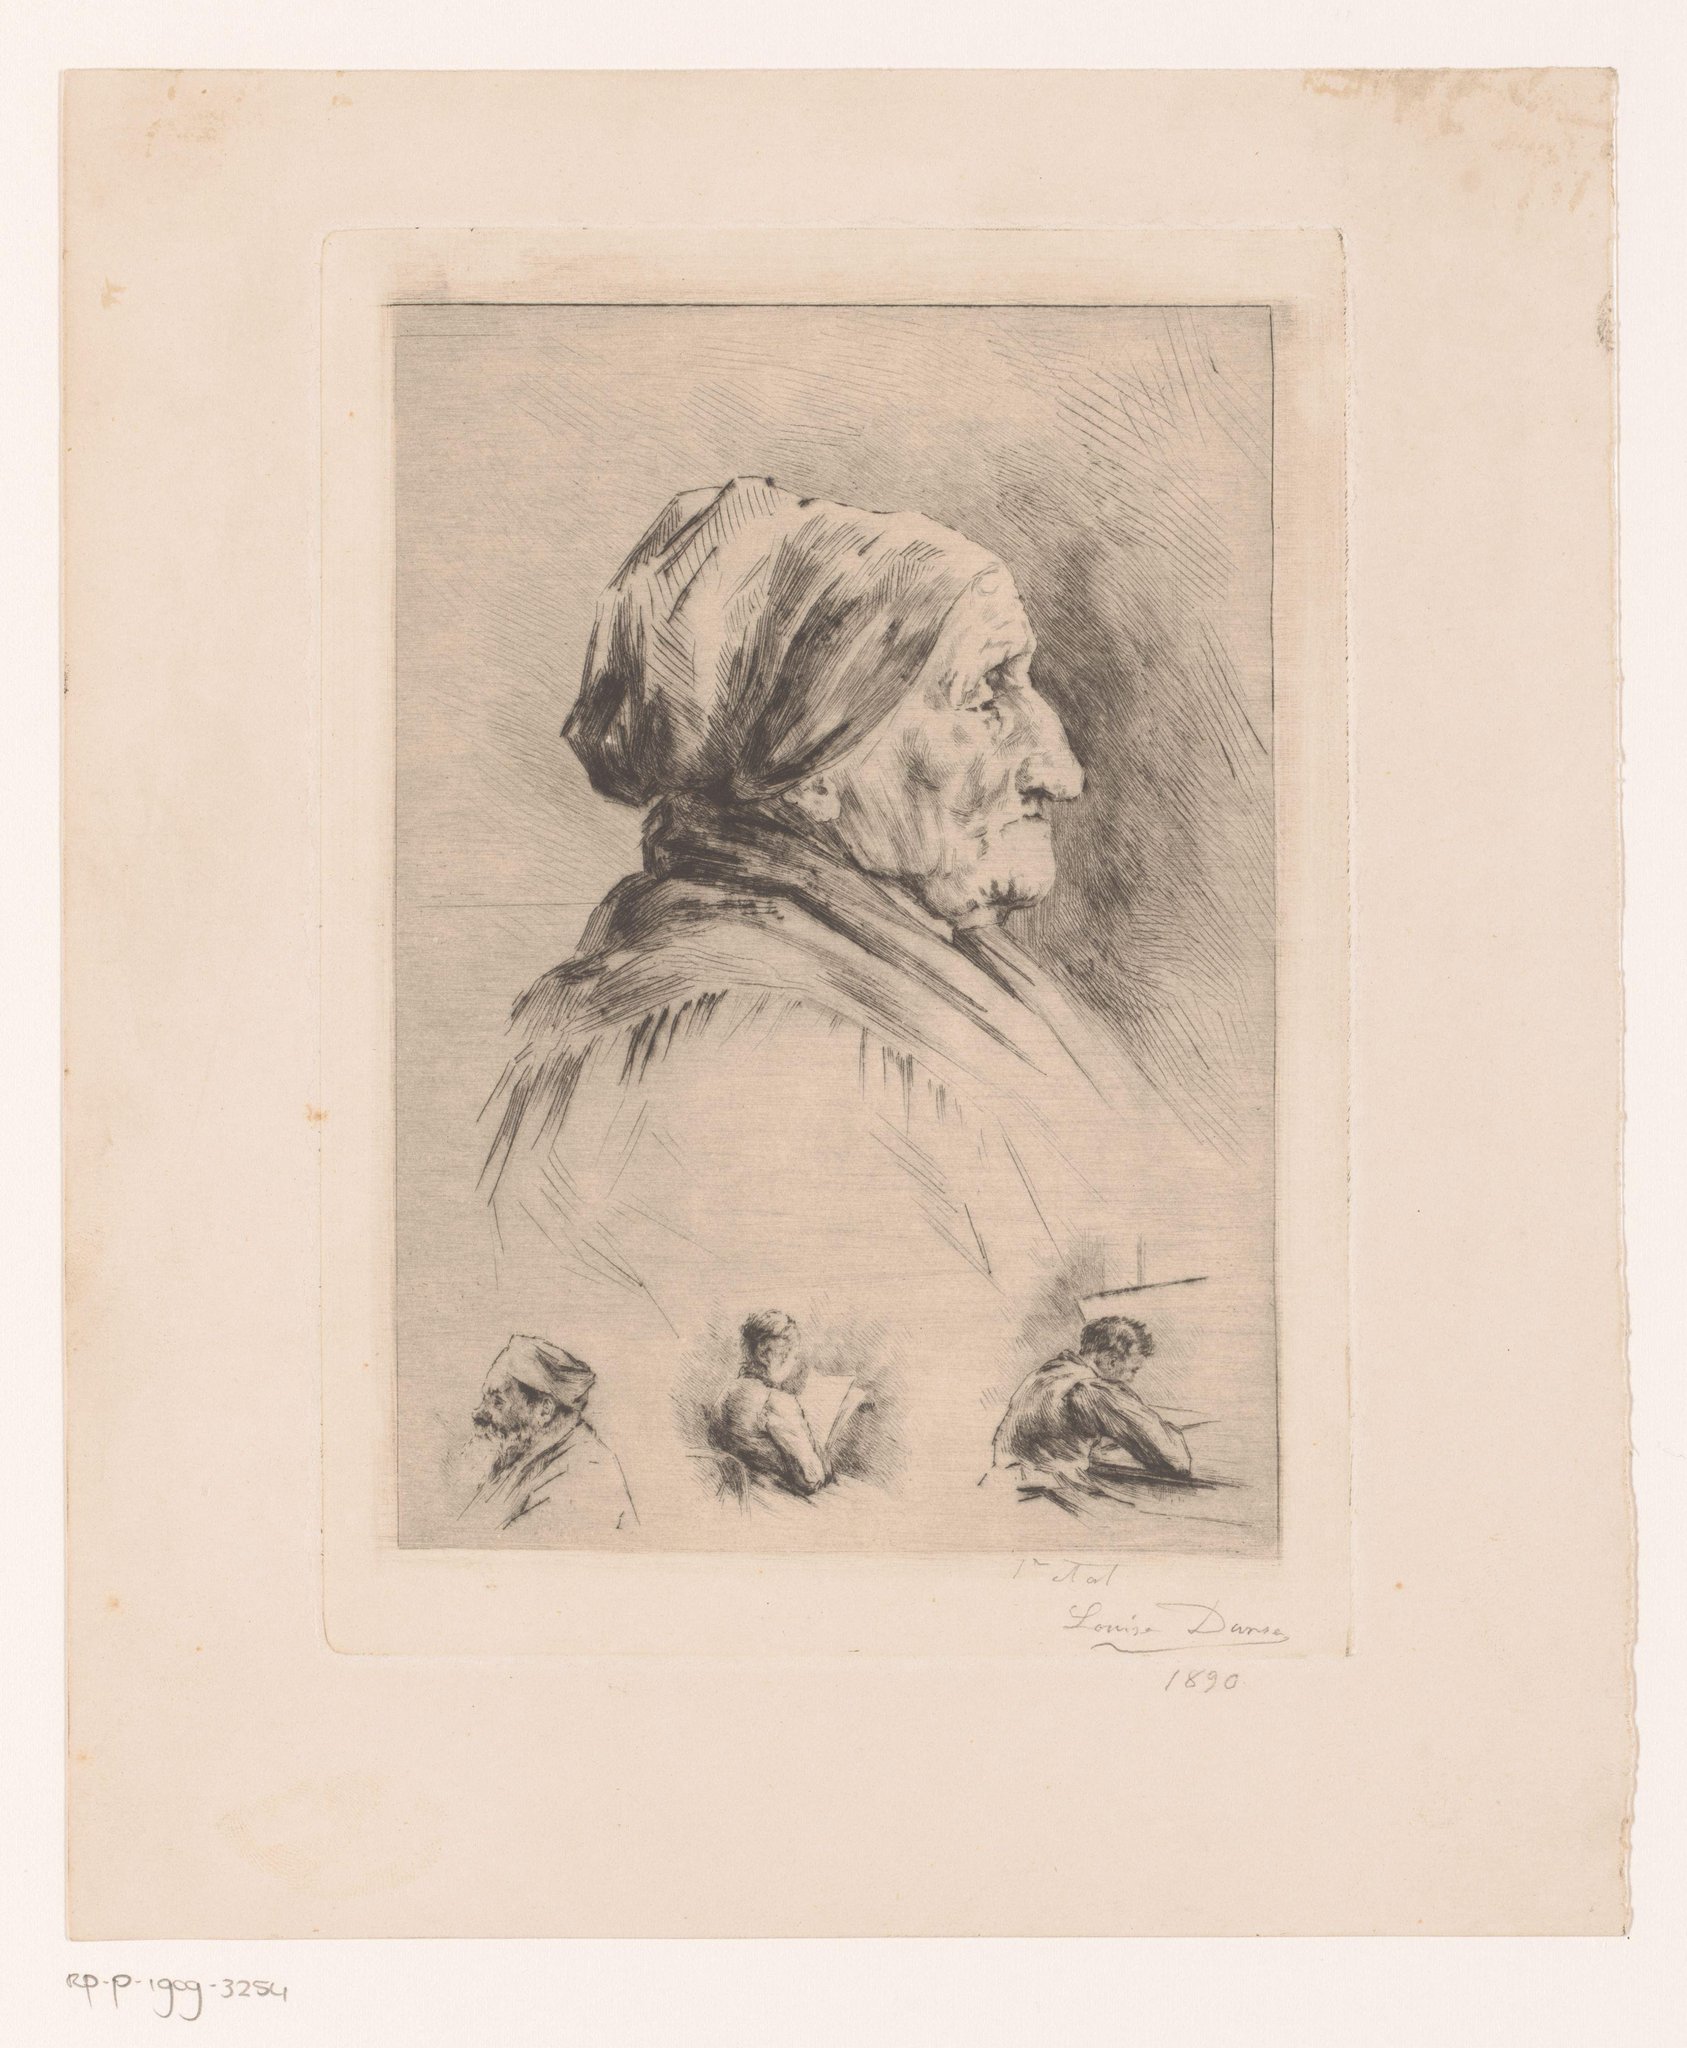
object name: print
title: Portret van een onbekende oude vrouw, daaronder drie kleinere portretstudies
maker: louise danse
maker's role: painter, print maker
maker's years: 1867-1948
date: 1890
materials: paper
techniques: drypoint, etching, intaglio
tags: anonymous historical person portrayed alone - bb - woman, old woman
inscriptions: collector's mark: Lugt 2228, annotation: ‘1er état’